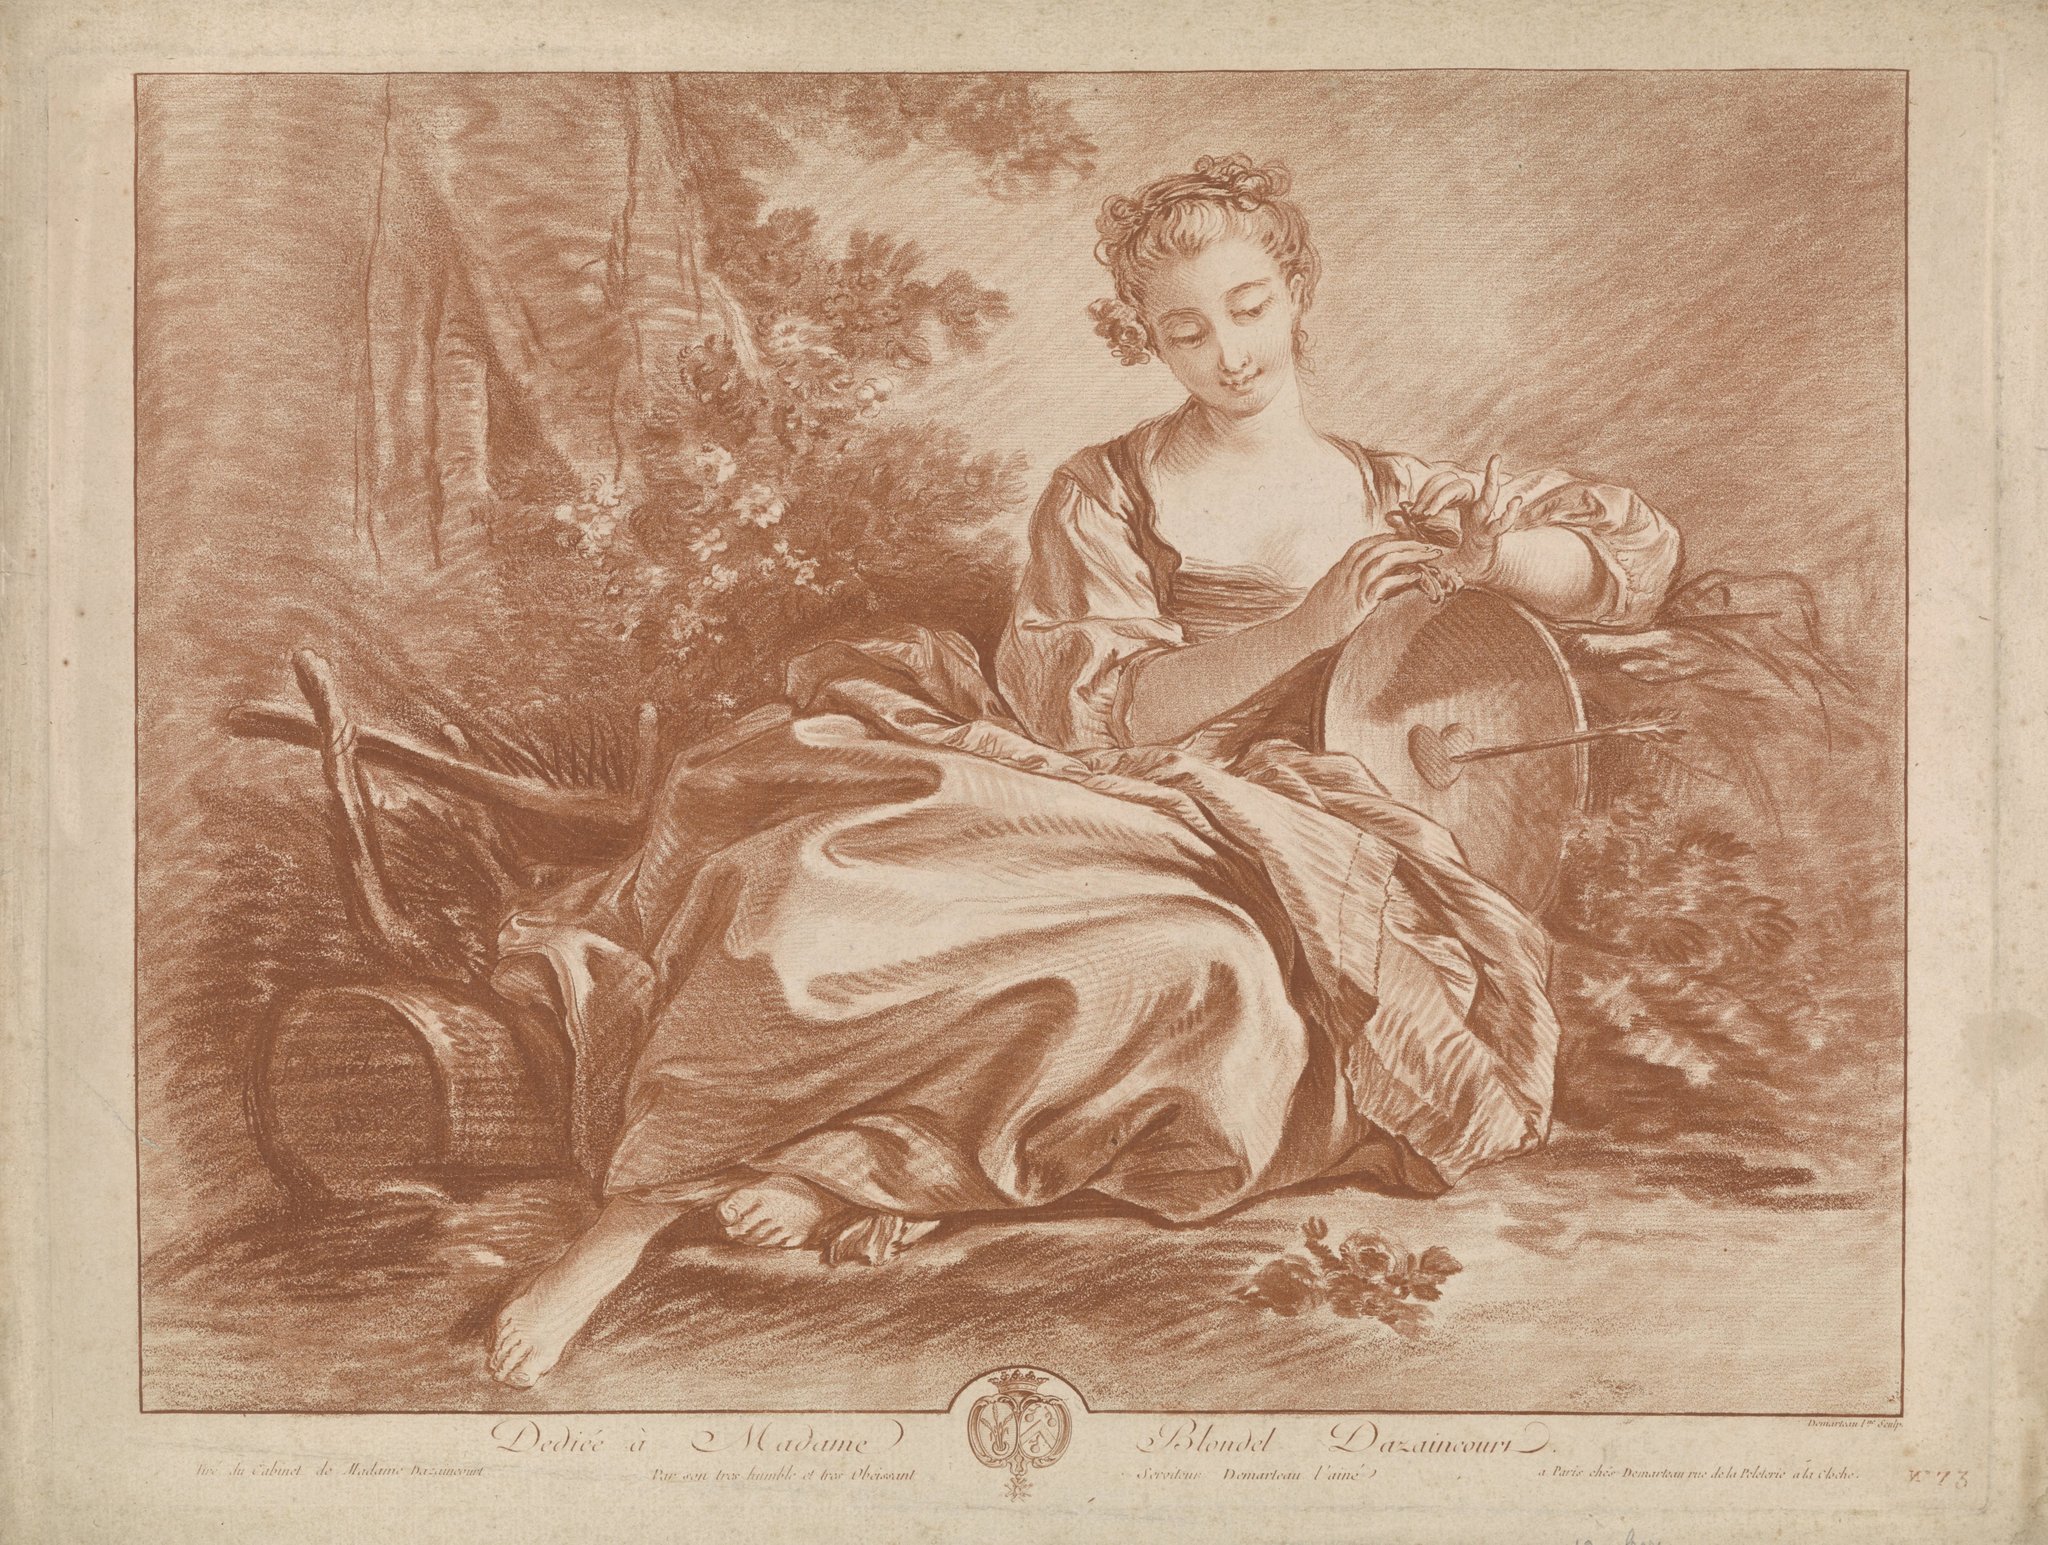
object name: print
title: Jonge vrouw zittend met schild waarop een met pijl doorboord hart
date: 1732-1776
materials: paper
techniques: printmaking, etching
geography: paris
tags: heart symbolism, one of the lovers alone (e.g. longing for the beloved)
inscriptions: collector's mark: Lugt 2228, collector's mark: Lugt 119